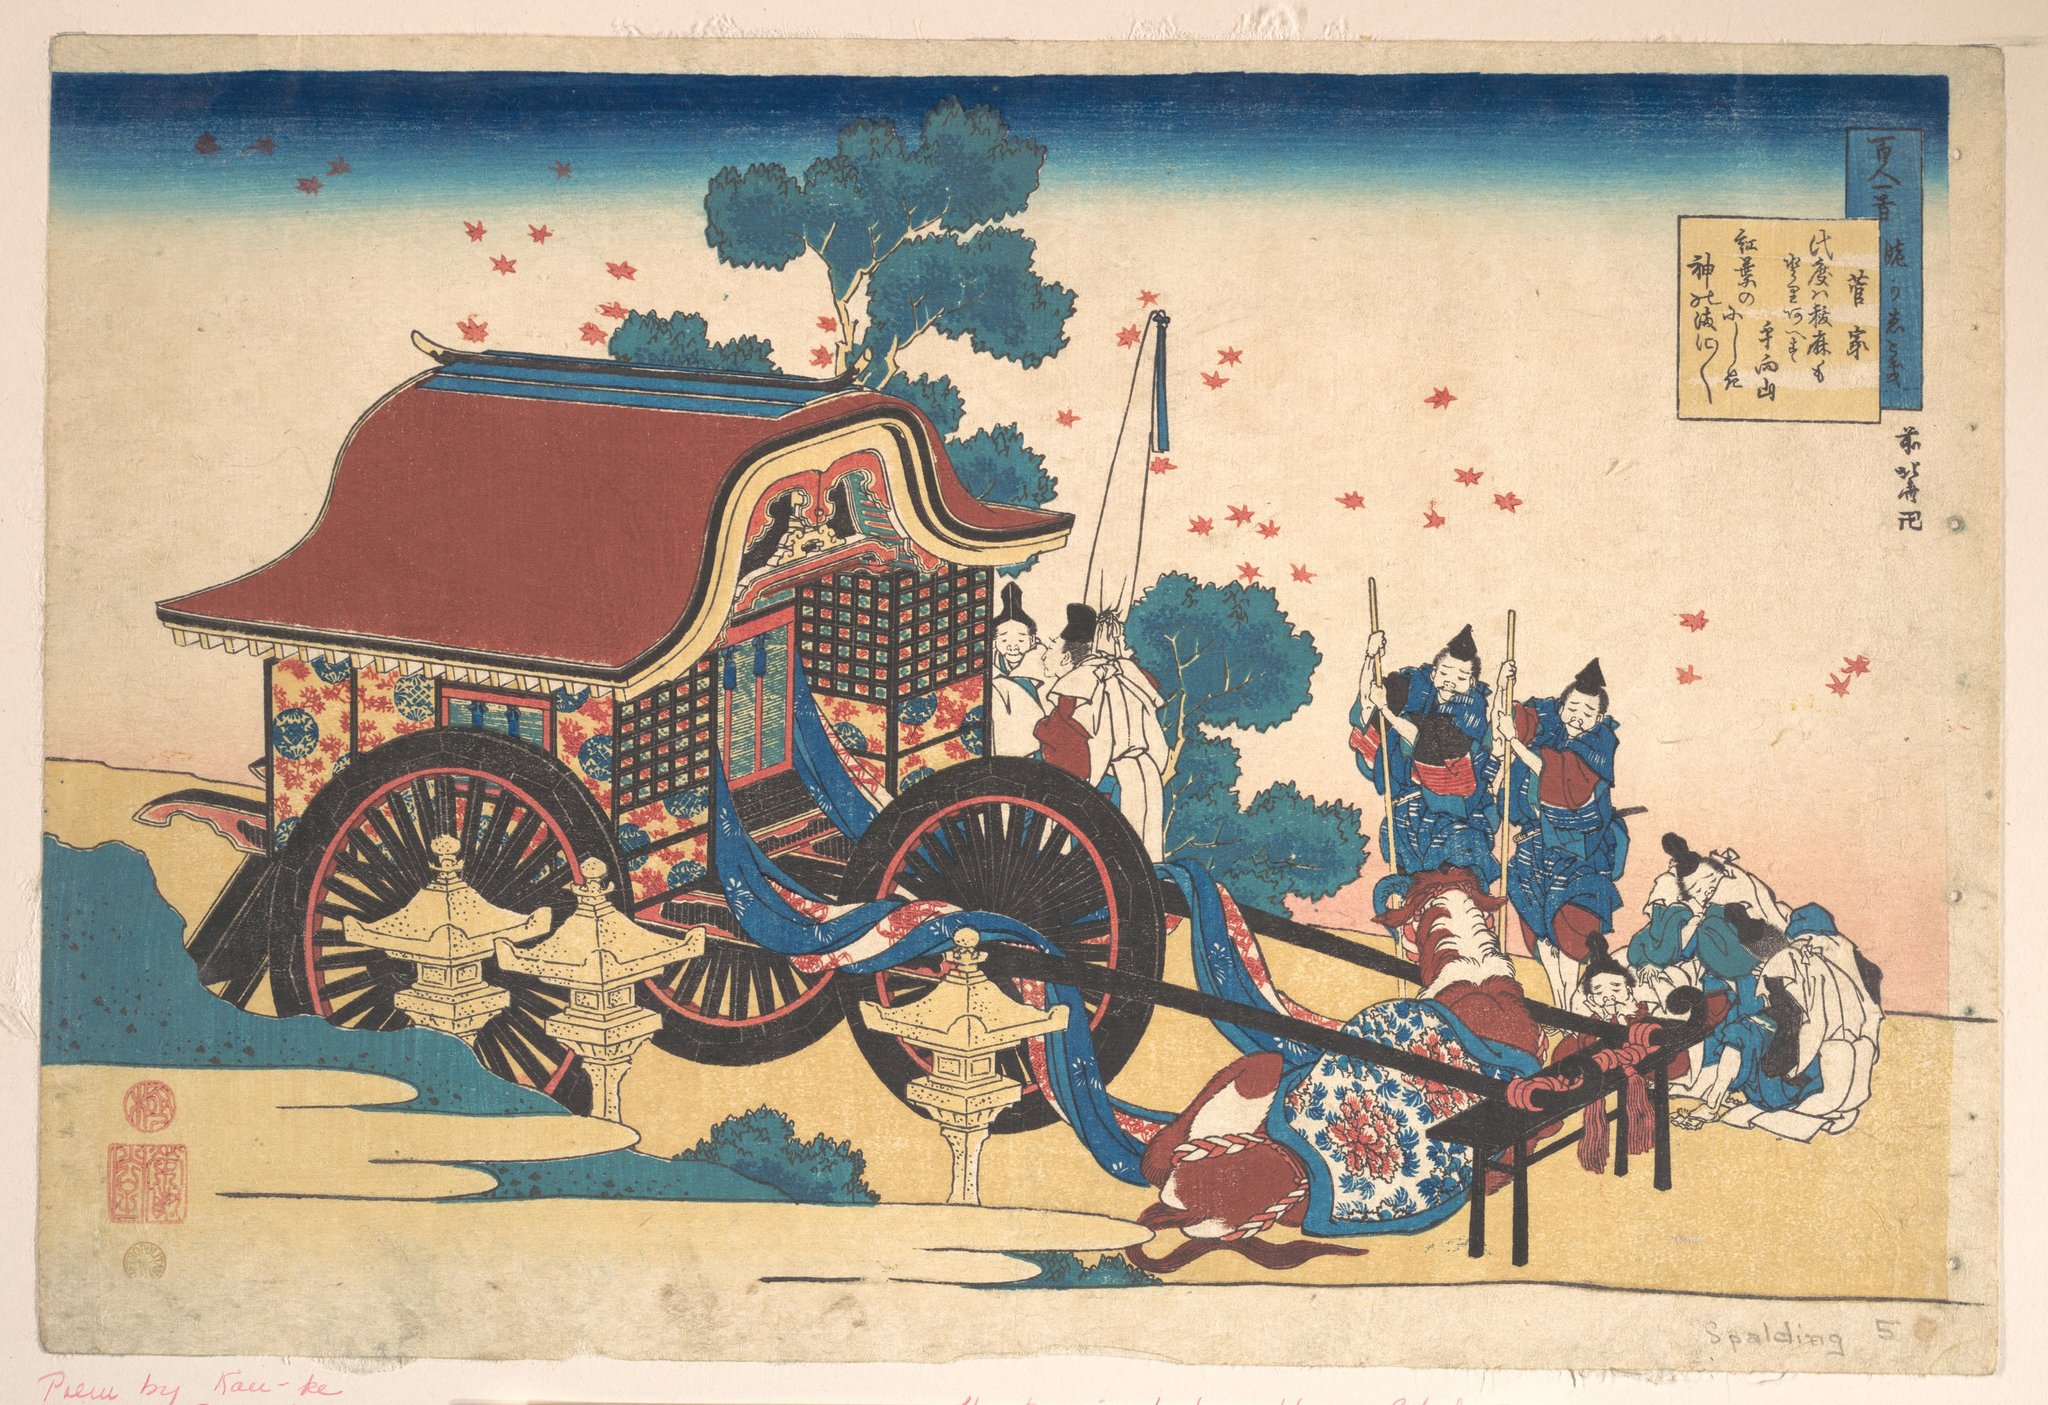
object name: woodblock print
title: Poem by Kanke (Sugawara Michizane), from the series One Hundred Poems Explained by the Nurse (Hyakunin isshu uba ga etoki)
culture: japanese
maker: katsushika hokusai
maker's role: artist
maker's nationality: japanese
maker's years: 1760-1849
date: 1839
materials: ink, paper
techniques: woodblock print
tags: poetry,men,bulls,carts